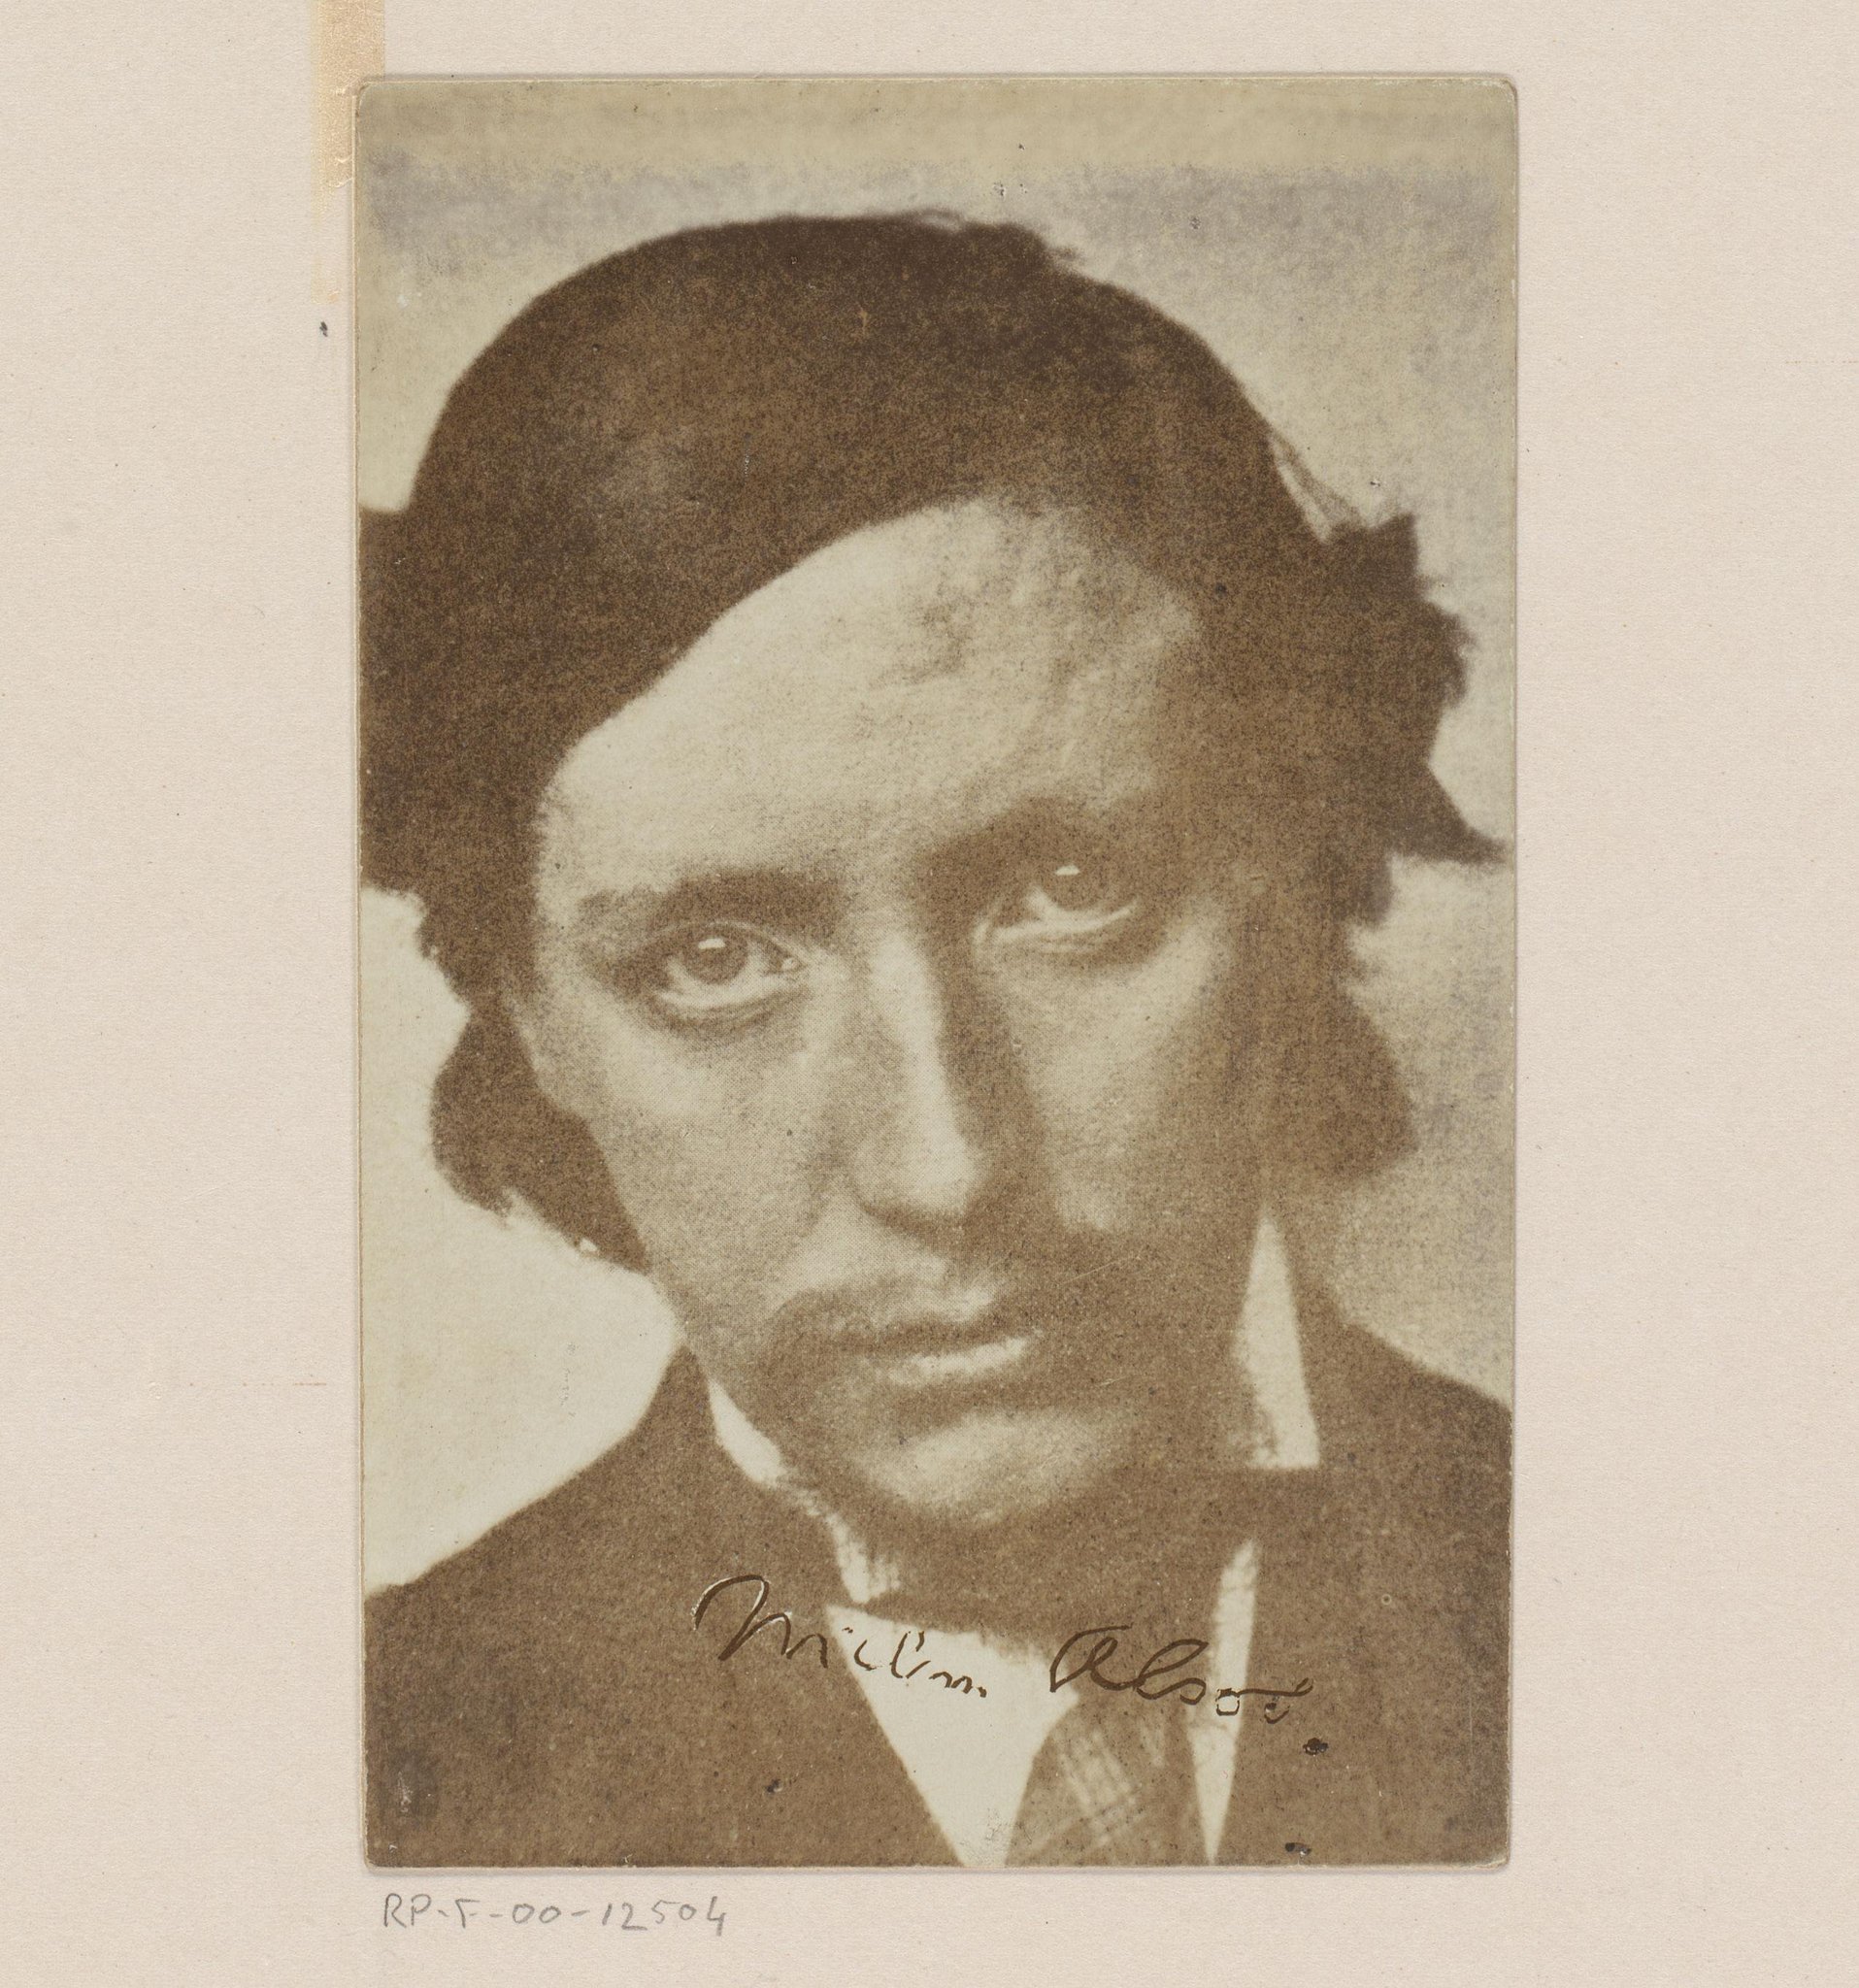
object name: photograph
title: Portret van Willem Kloos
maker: willem witsen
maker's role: draughtsman, painter, print maker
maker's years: 1860-1923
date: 1892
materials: paper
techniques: gelatin silver print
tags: amsterdam, the hague, willem kloos, historical persons